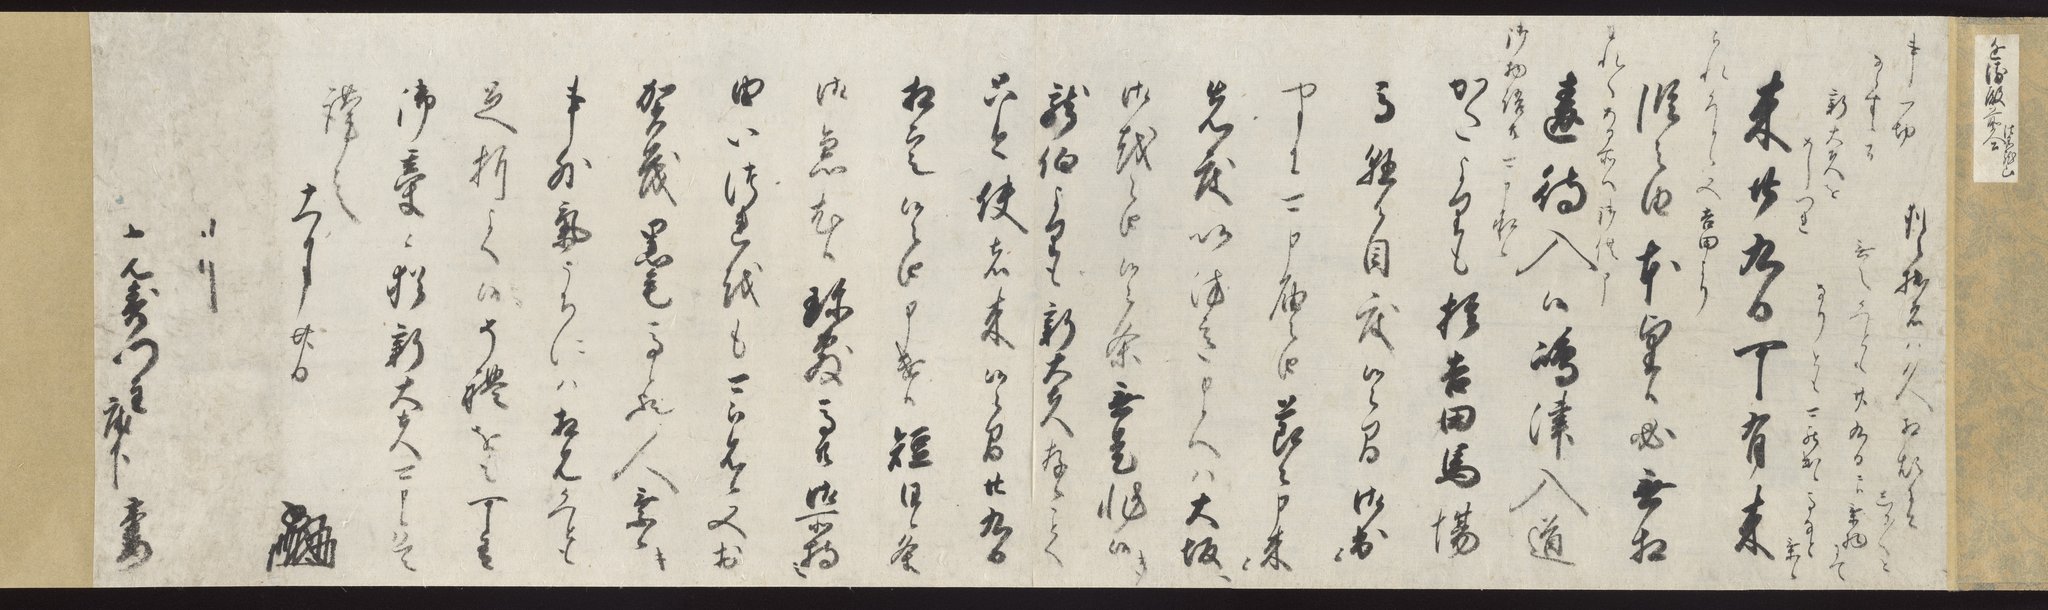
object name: handscroll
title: Letter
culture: japanese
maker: konoe sakihisa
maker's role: artist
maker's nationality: japanese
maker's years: 1536-1612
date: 1536-1612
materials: ink, paper